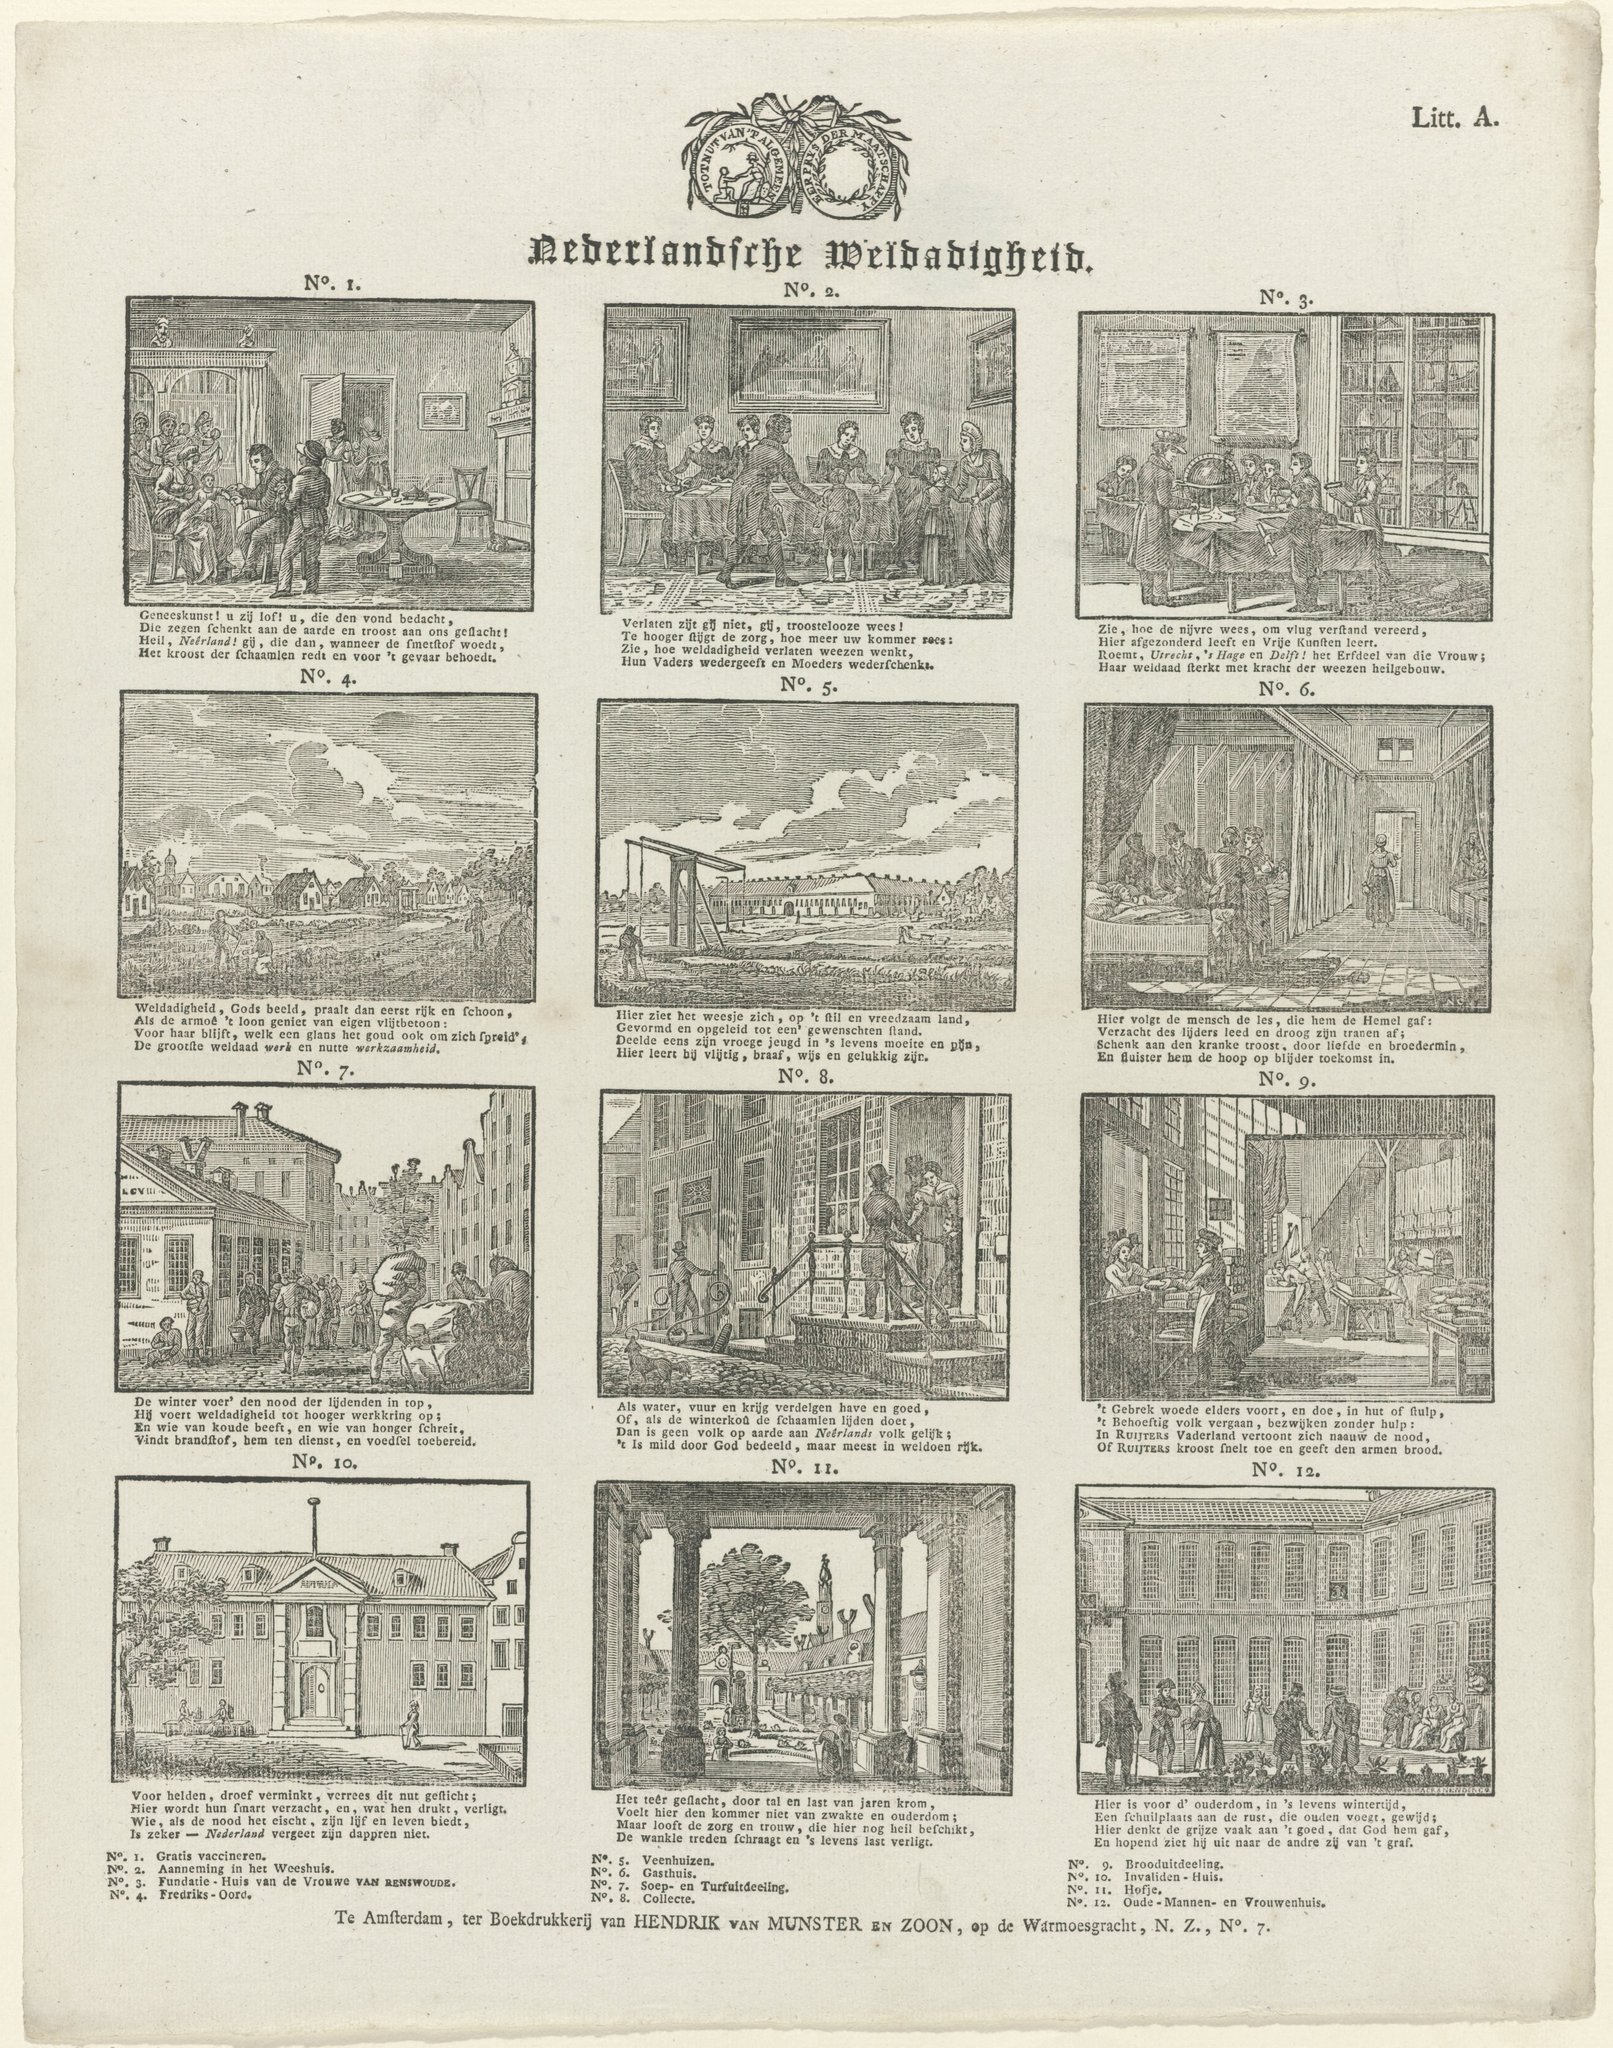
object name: print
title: Prenten uitgegeven door de maatschappij: / Tot nut van 't algemeen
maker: alexander cranendoncq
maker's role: draughtsman, print maker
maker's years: 1799-1869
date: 1818-1829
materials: paper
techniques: letterpress printing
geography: netherlands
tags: foundling-hospital, vaccination, orphanage, charitable works, netherlands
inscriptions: collector's mark: Lugt 2760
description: Blad met 12 voorstellingen over weldadigheid in Nederland, waaronder weergaven van gratis vaccineren, gasthuizen en brooduitdeling. Boven elke afbeelding een nummer en onder elke afbeelding een vierregelig vers. Onder aan het blad een legenda met de titels bij de prenten. Midden boven het zegel van de Maatschappij tot Nut van 't Algemeen. Gemerkt rechtsboven: Litt. A.